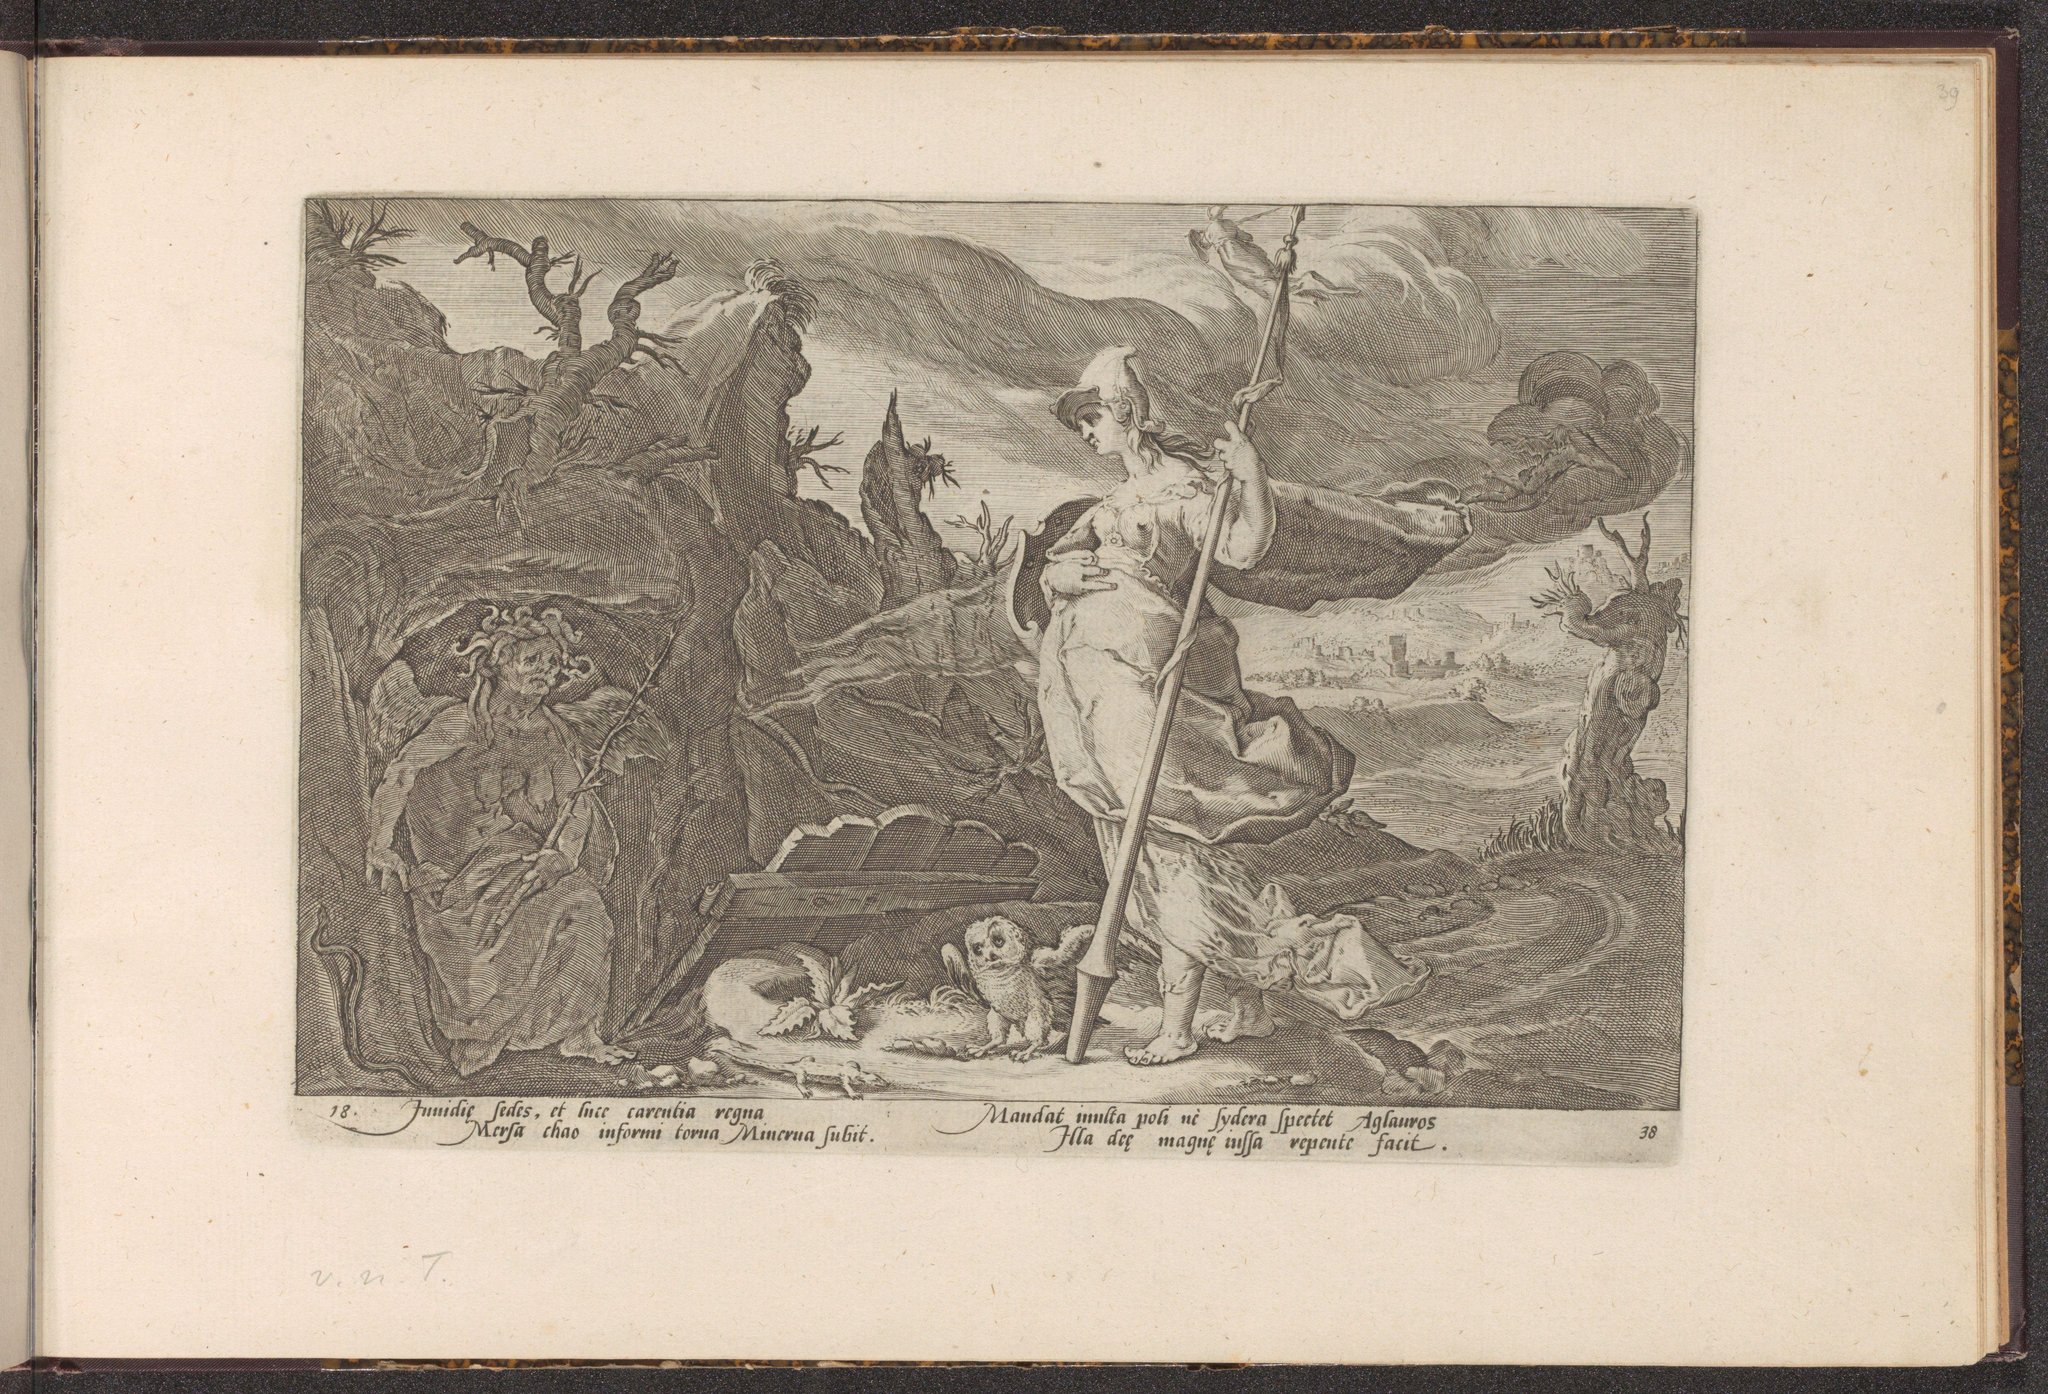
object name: album leaf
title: Minerva vraagt Nijd om jaloezie in Aglauros te ontsteken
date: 1590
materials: paper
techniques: engraving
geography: haarlem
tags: minerva visits the cave of envy (invidia) in order to punish aglauros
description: Minerva staat bij de grot waar Nijd huist en vraagt haar om Aglauros jaloers te maken op haar zus Herse. De godin is nog boos op Aglauros: zij nam indertijd het initiatief tot het openen van de mand met Erichthonius, die Minerva aan de dochters van Cecrops had toevertrouwd op voorwaarde dat ze hem dicht zouden laten. Onder de voorstelling twee keer twee versregels in het Latijn. De prent maakt deel uit van een album.